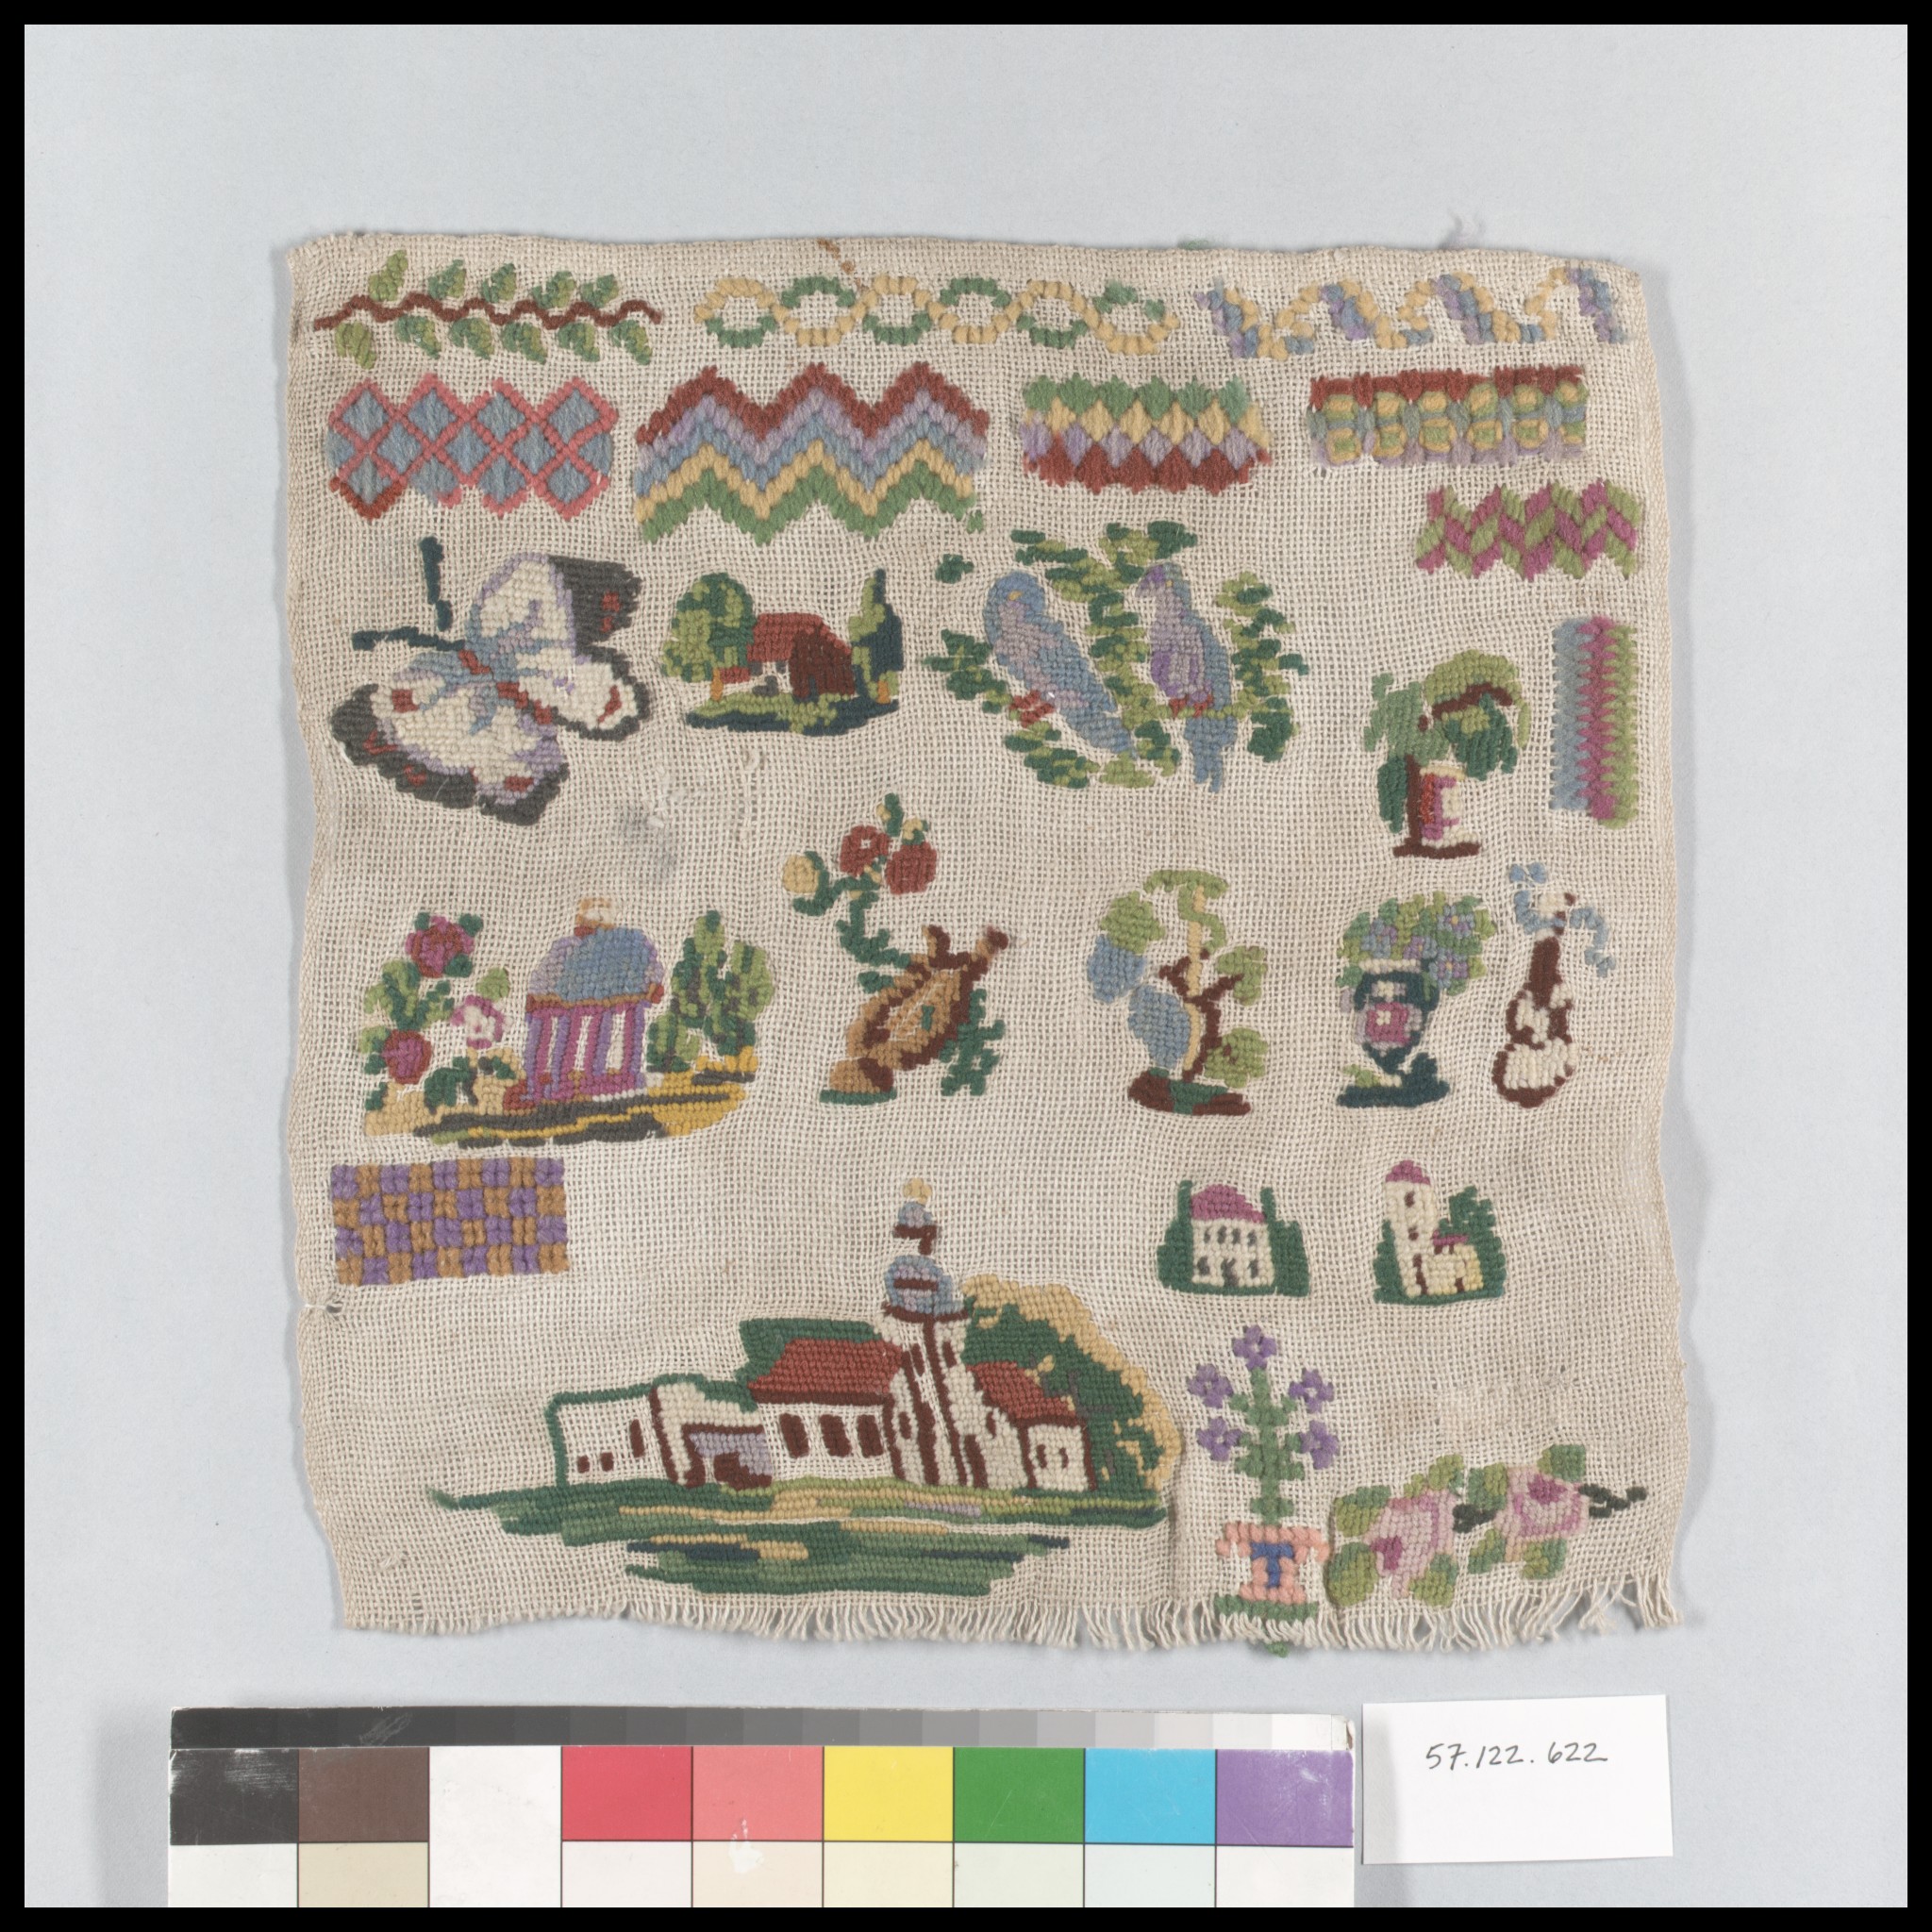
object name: sampler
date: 1801-1900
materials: canvas, wool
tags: birds,houses,butterflies